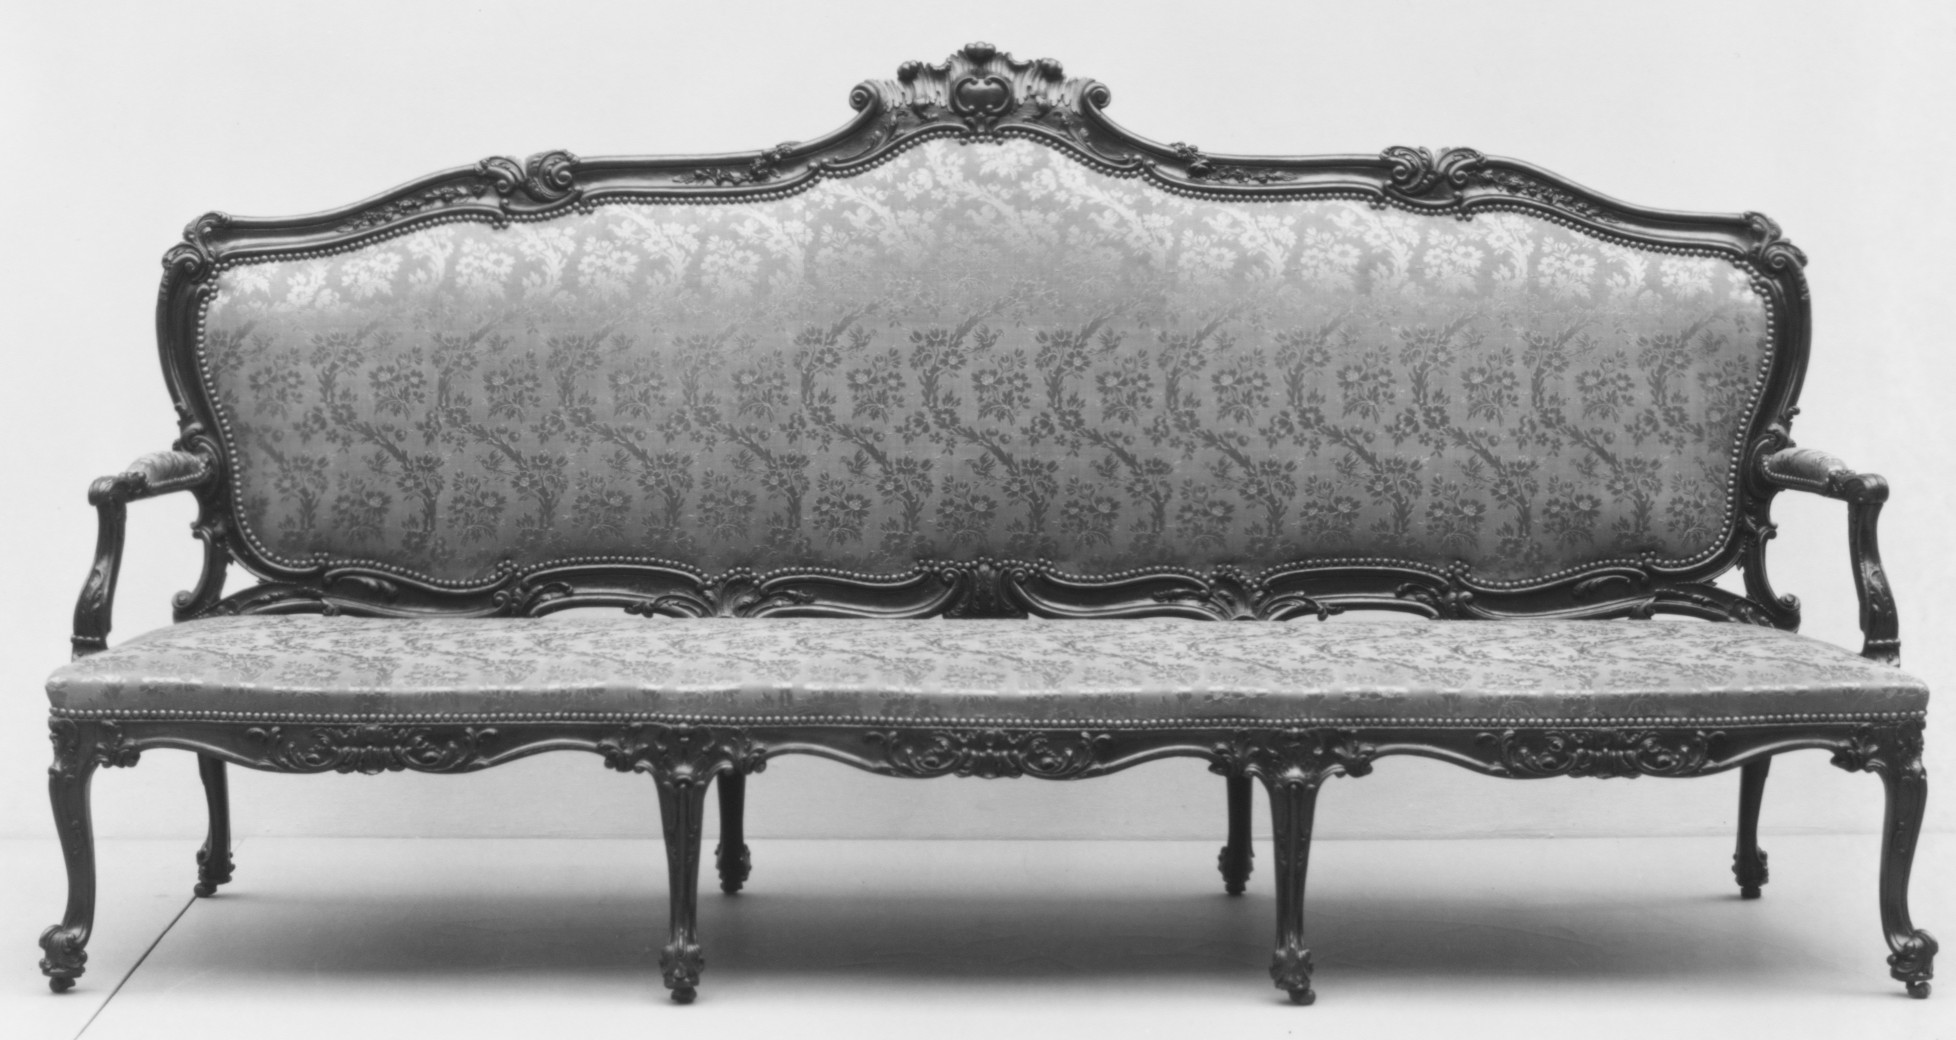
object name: settee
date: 1760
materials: wood